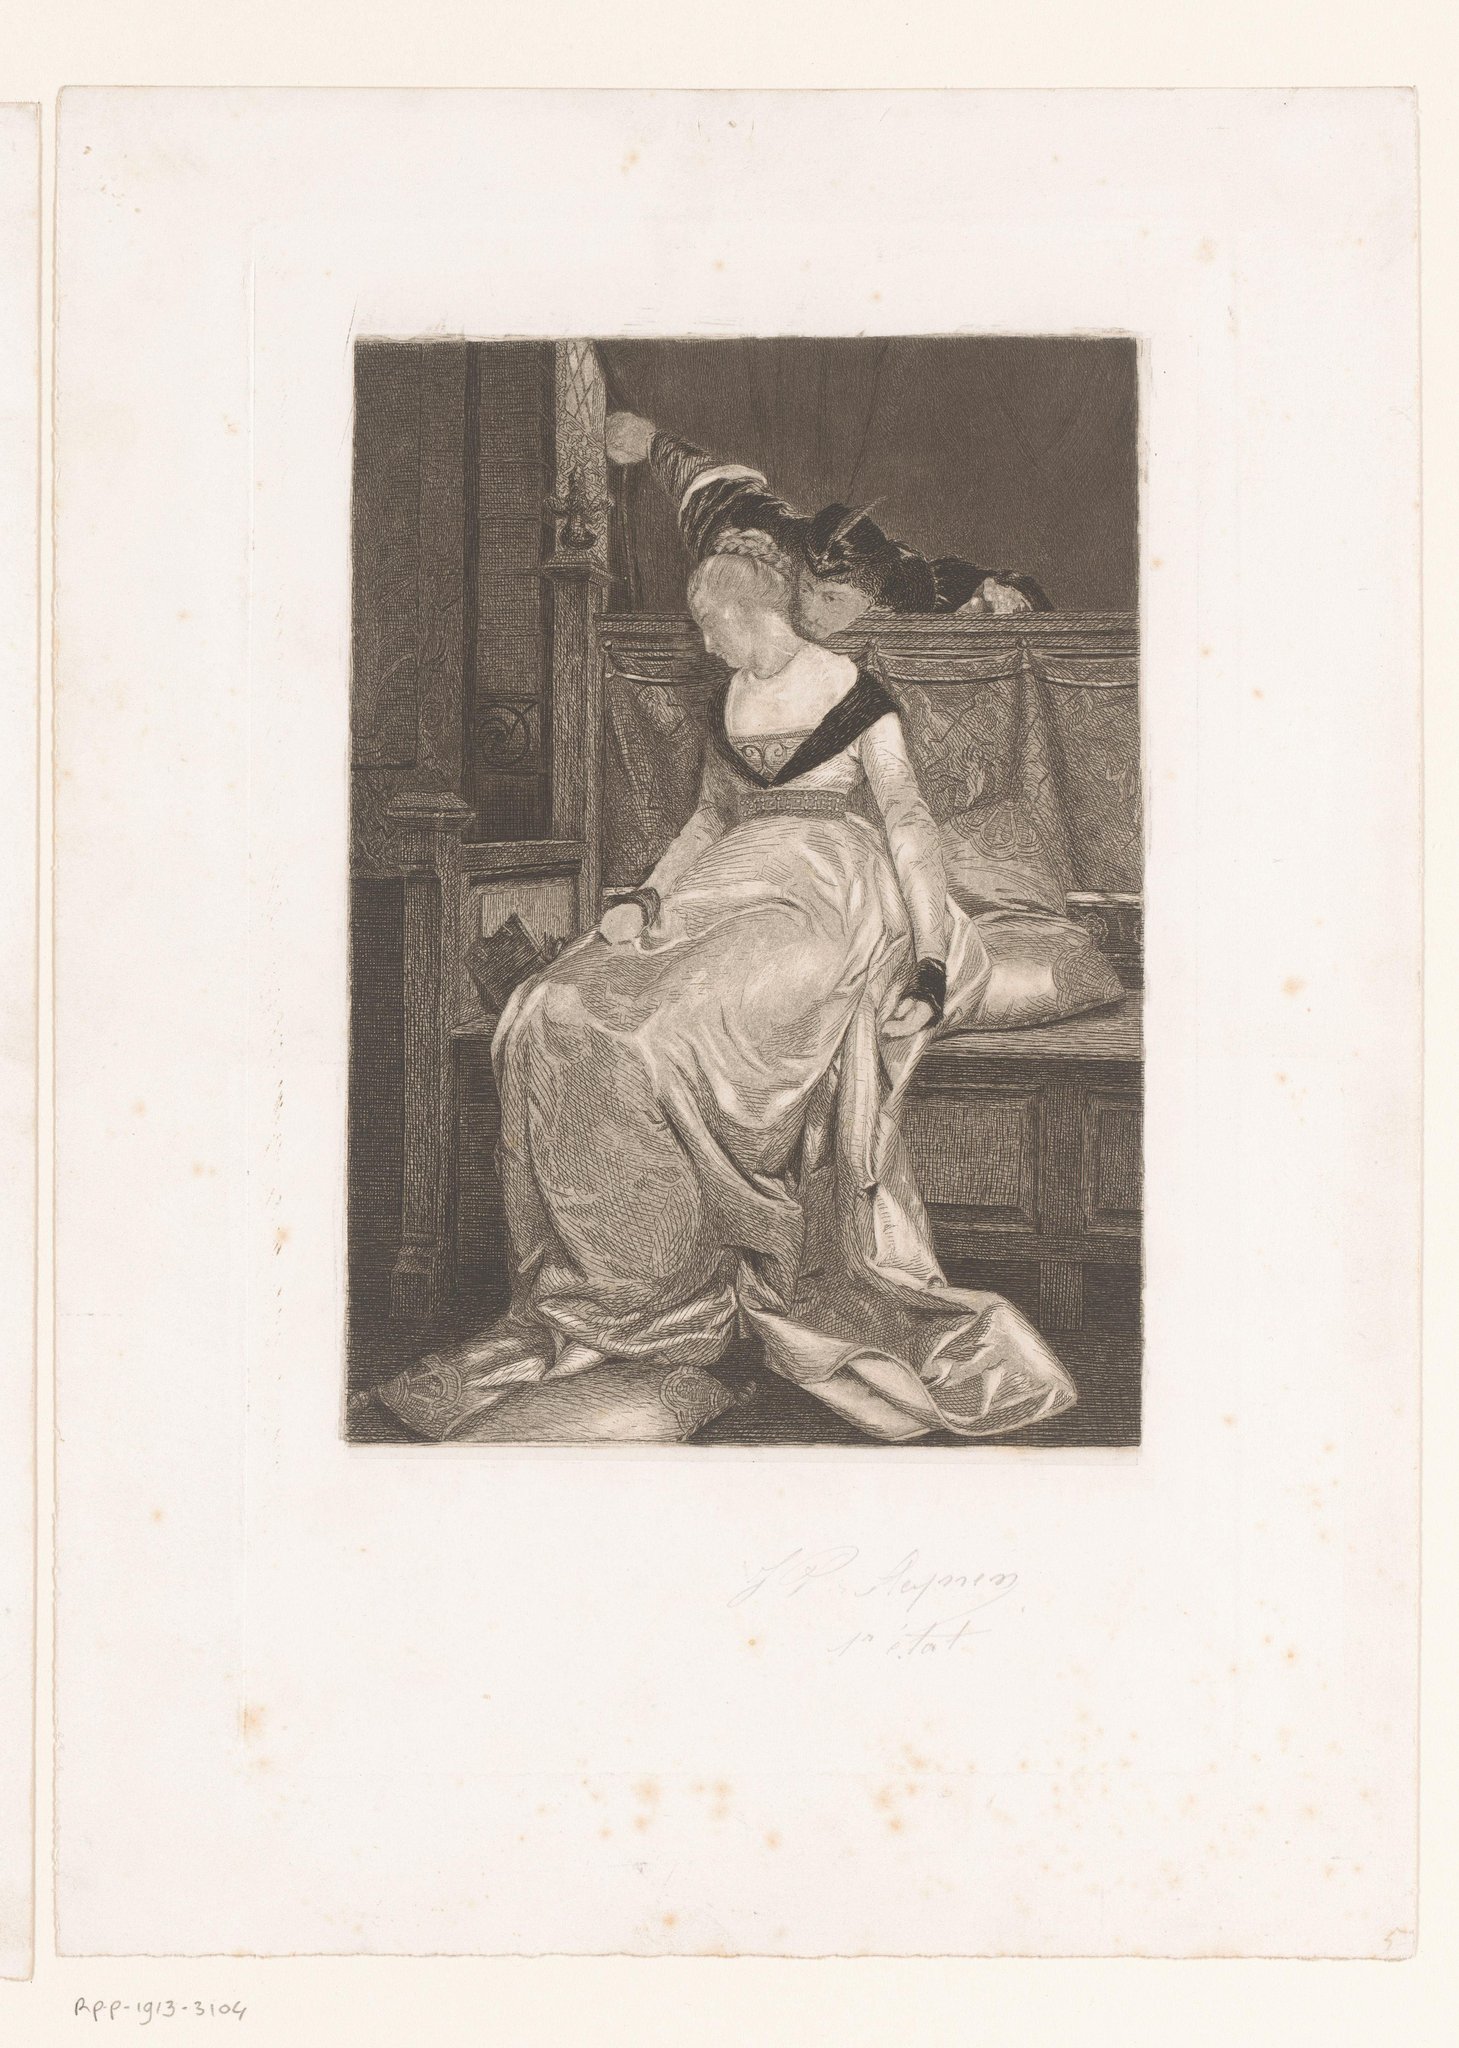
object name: print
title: Man probeert een jonge, slapende vrouw op een bank te kussen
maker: joseph paul steynen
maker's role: print maker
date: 1850-1913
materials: paper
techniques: aquatint, etching, intaglio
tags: bench, lips pressed together as for a kiss, sleeping; unconsciousness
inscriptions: collector's mark: Lugt 2228, inscription: ‘1e état’